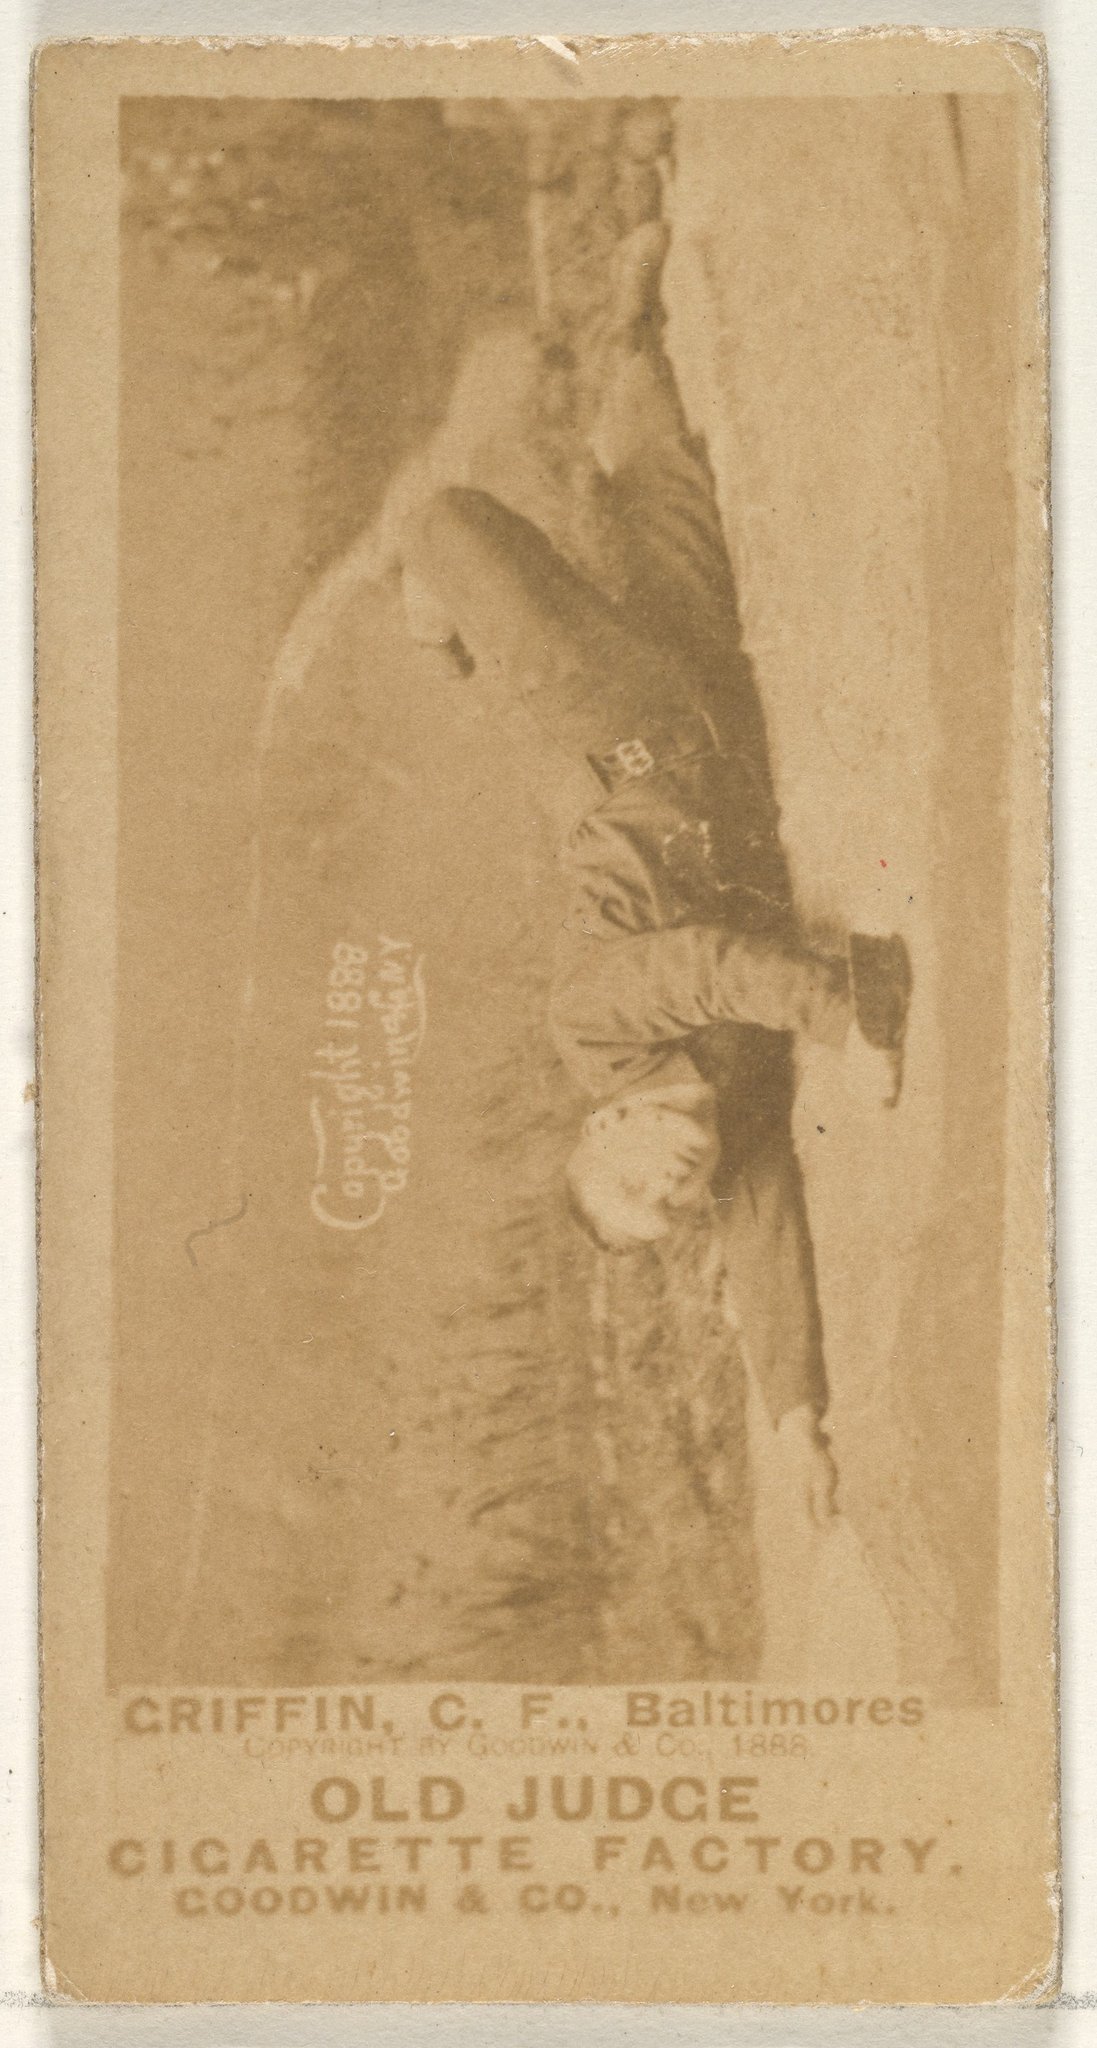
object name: baseball card, photograph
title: Griffin, Center Field, Baltimore Orioles, from the Old Judge series (N172) for Old Judge Cigarettes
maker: goodwin & company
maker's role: publisher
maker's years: 1850-1950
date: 1888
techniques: albumen silver print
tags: men,portraits,baseball,athletes